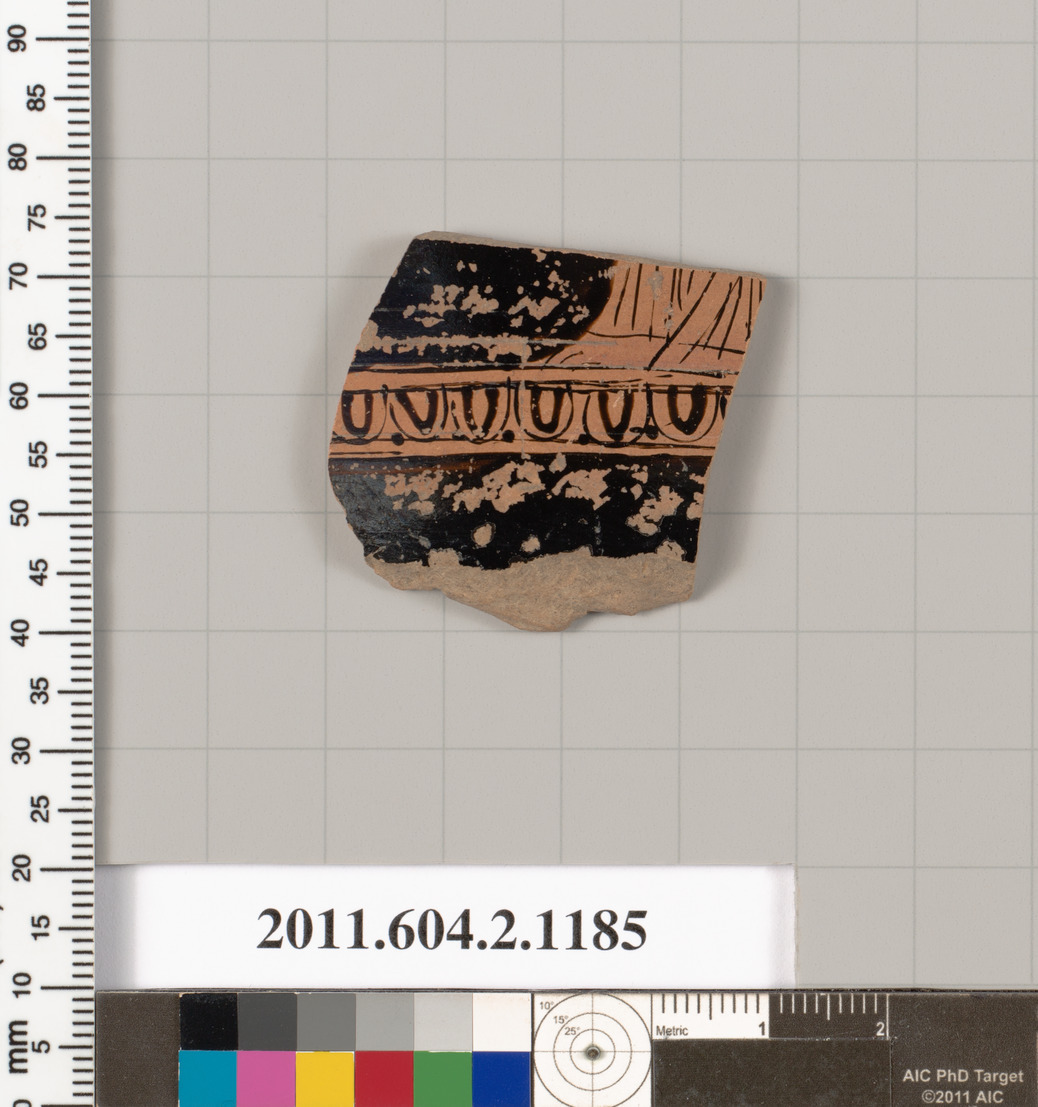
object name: lekythos fragment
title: Terracotta fragment of a squat lekythos (oil flask)?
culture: greek, attic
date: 425-401 BCE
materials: terracotta